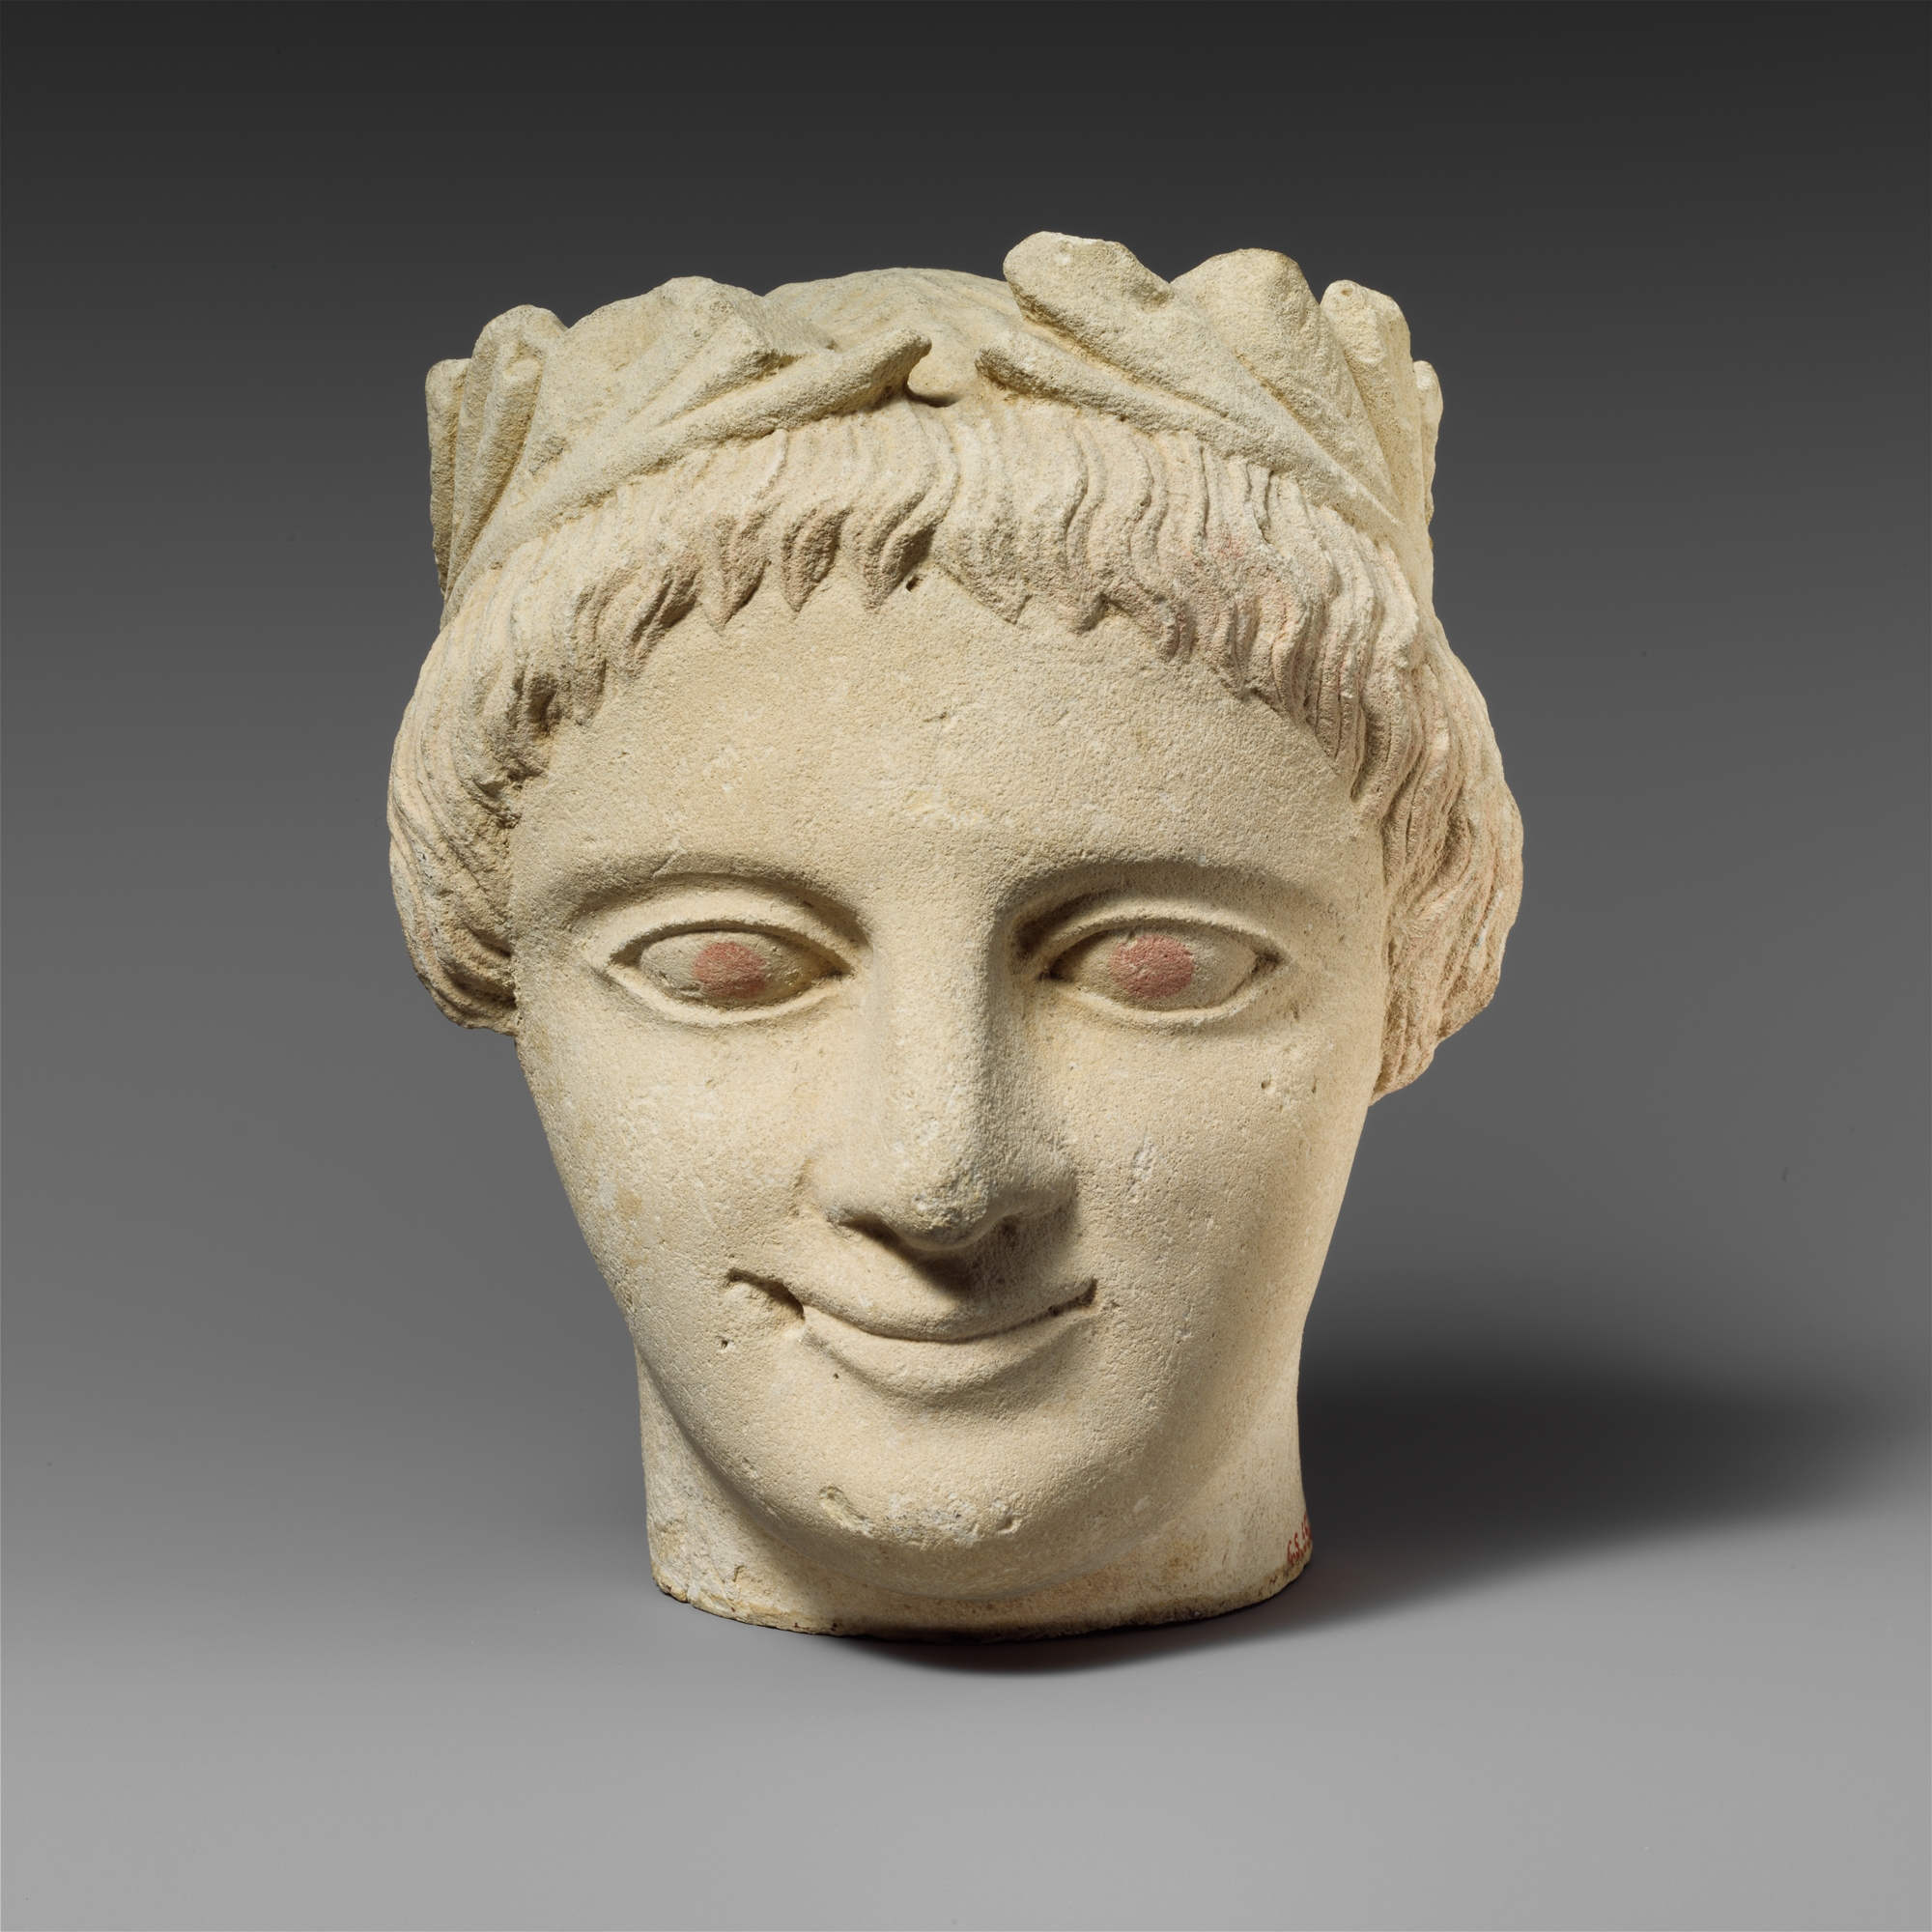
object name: head of a male votary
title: Limestone head of a beardless male votary with a wreath of leaves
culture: cypriot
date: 450-401 BCE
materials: limestone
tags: heads,men,wreaths